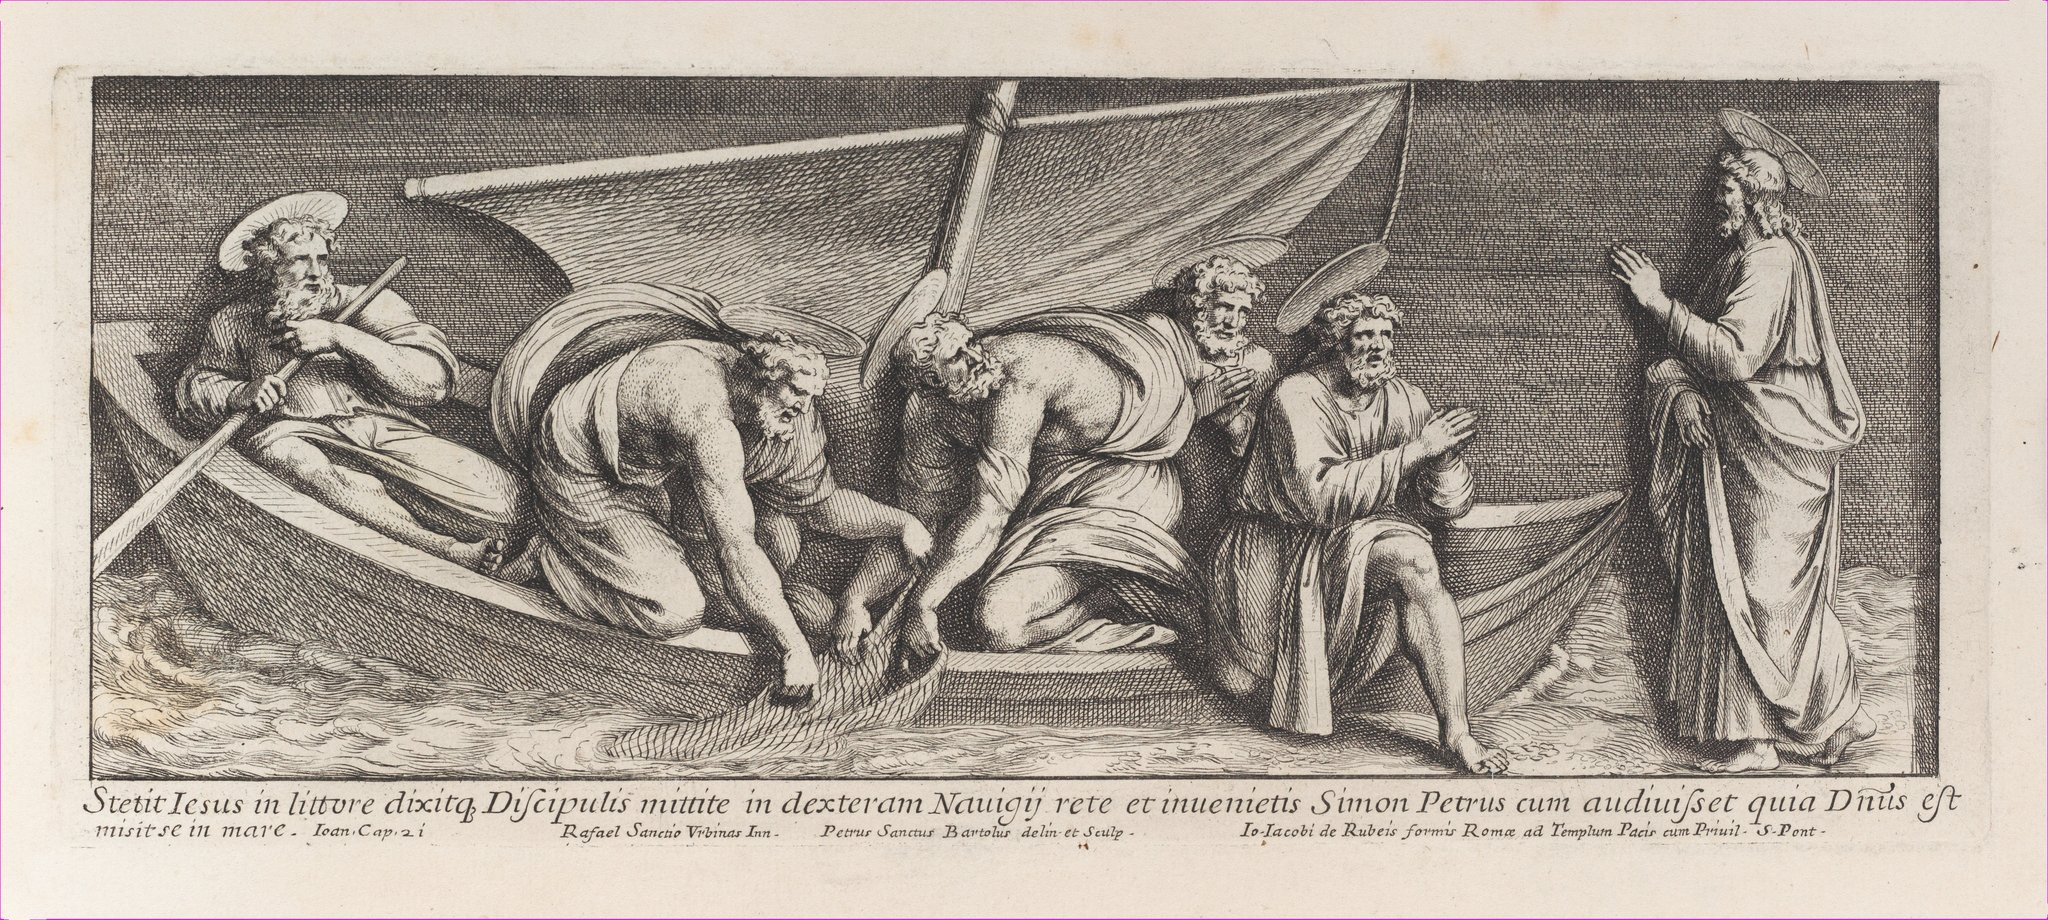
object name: print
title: Christ speaking with Saint Peter, who kneels before him in adoration and with his hands joined in prayer, while the Apostles draw up their nets behind him, after Raphael's Stanza dell'incendio del Borgo, from a series of 15 plates, depicting Raphael's works for the Vatican stanze and the Sistine Chapel tapestries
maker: pietro santi bartoli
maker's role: artist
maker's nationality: italian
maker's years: 1615-1700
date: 1650-1670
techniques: etching